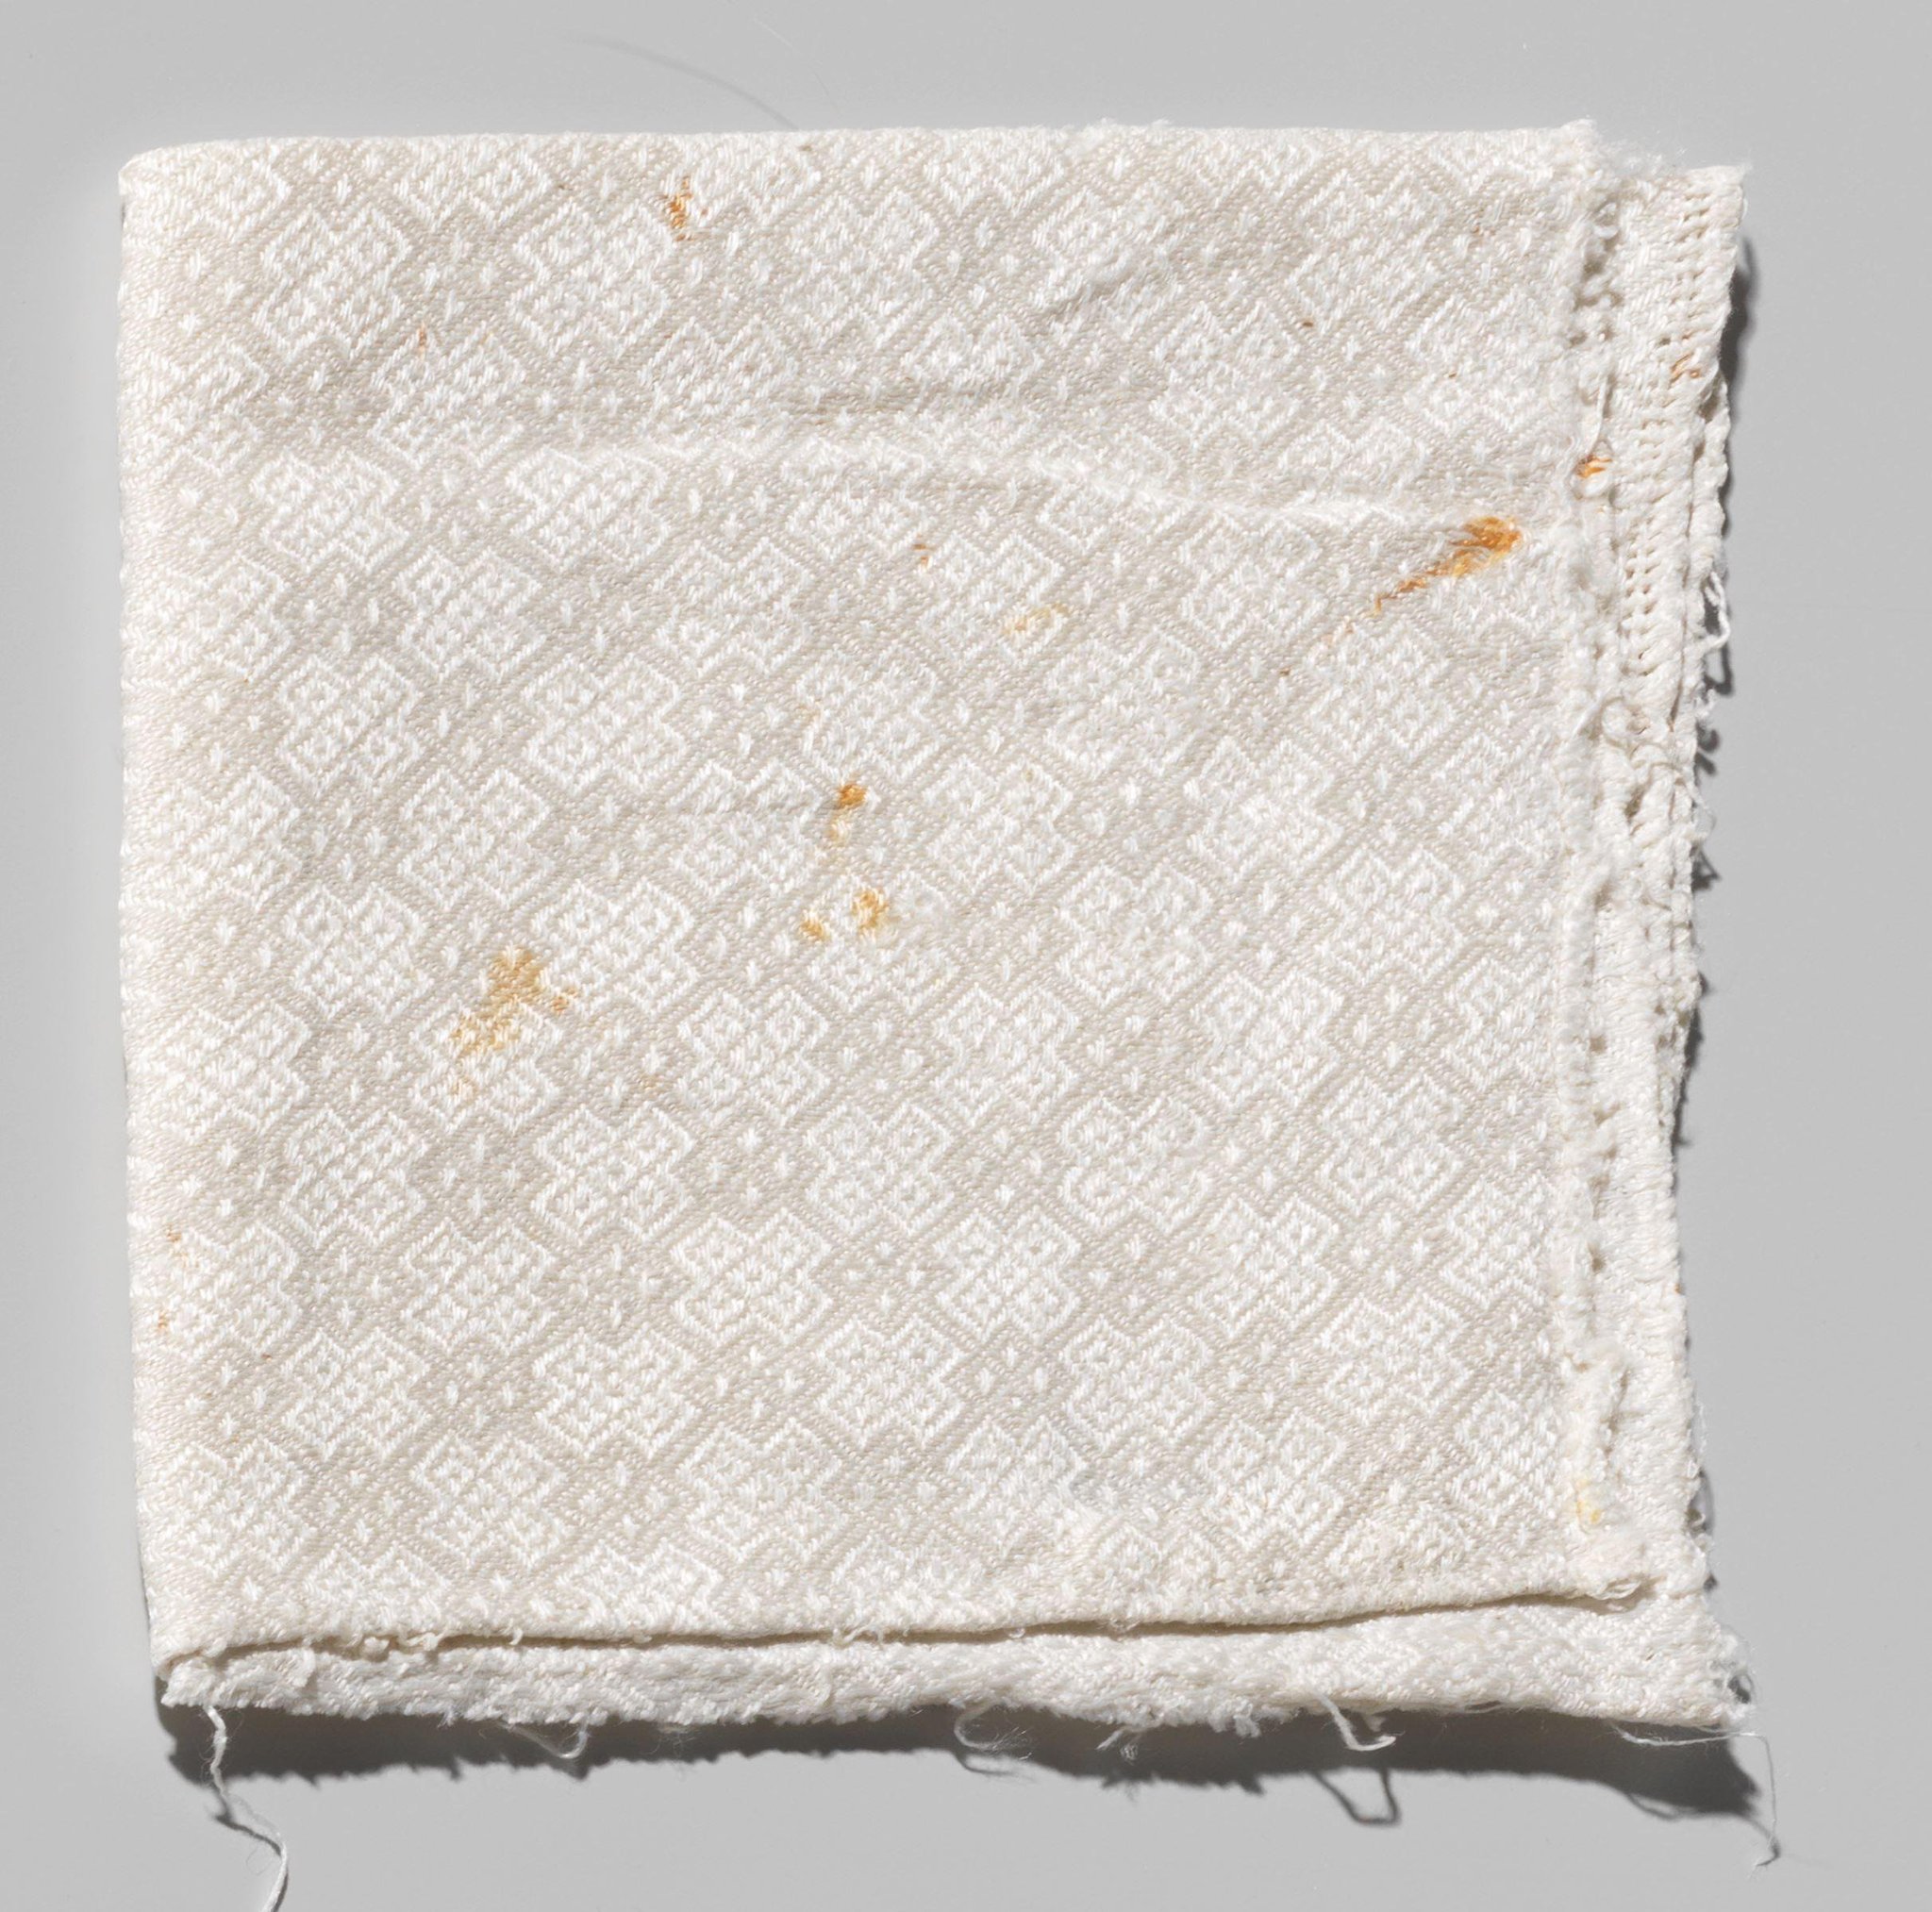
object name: fragment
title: Servet, fragment van wit linnendamast met patroon van ruitwerk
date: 1600-1699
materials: linen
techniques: peeled fabric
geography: netherlands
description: Servet, fragment van wit linnendamast met een patroon van ruitwerk met vier ruiten op de kruispunten en als binnenvulling een kruis met vijf ruiten.